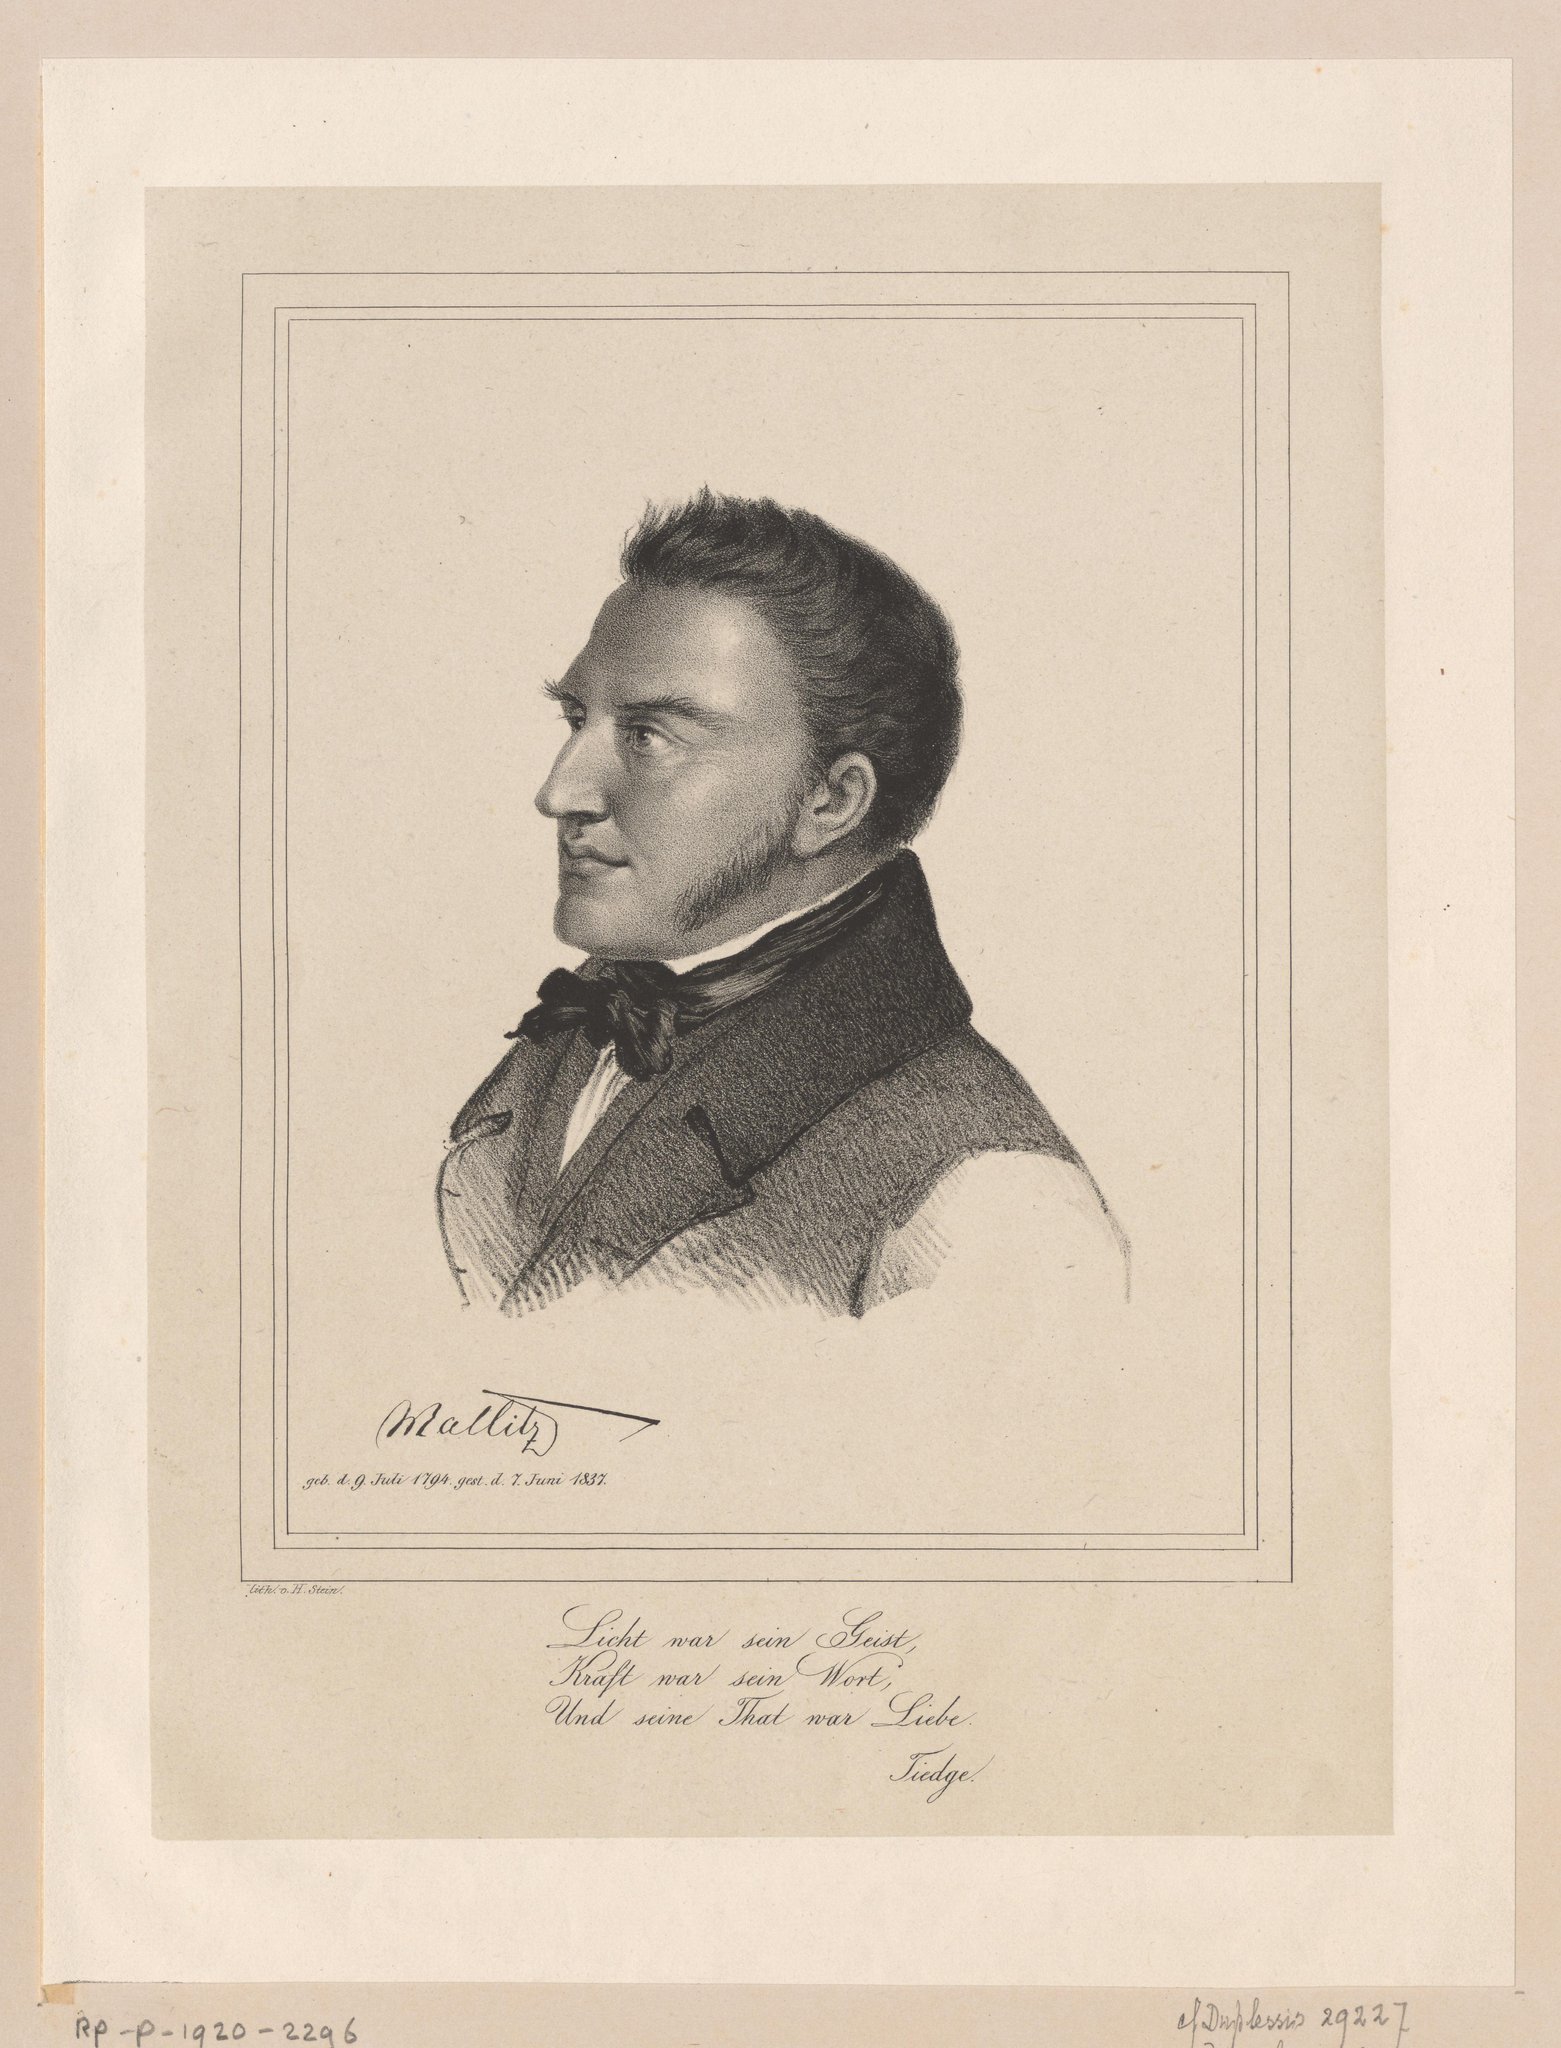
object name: print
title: Portret van Gotthilf August von Maltitz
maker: christoph august tiedge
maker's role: dichter, secretaris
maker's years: 1752-1841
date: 1837-1839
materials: paper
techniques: lithograph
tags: historical persons, portrait of a writer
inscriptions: collector's mark: Lugt 2228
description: Met drieregelig vers in het Duits onder het portret.